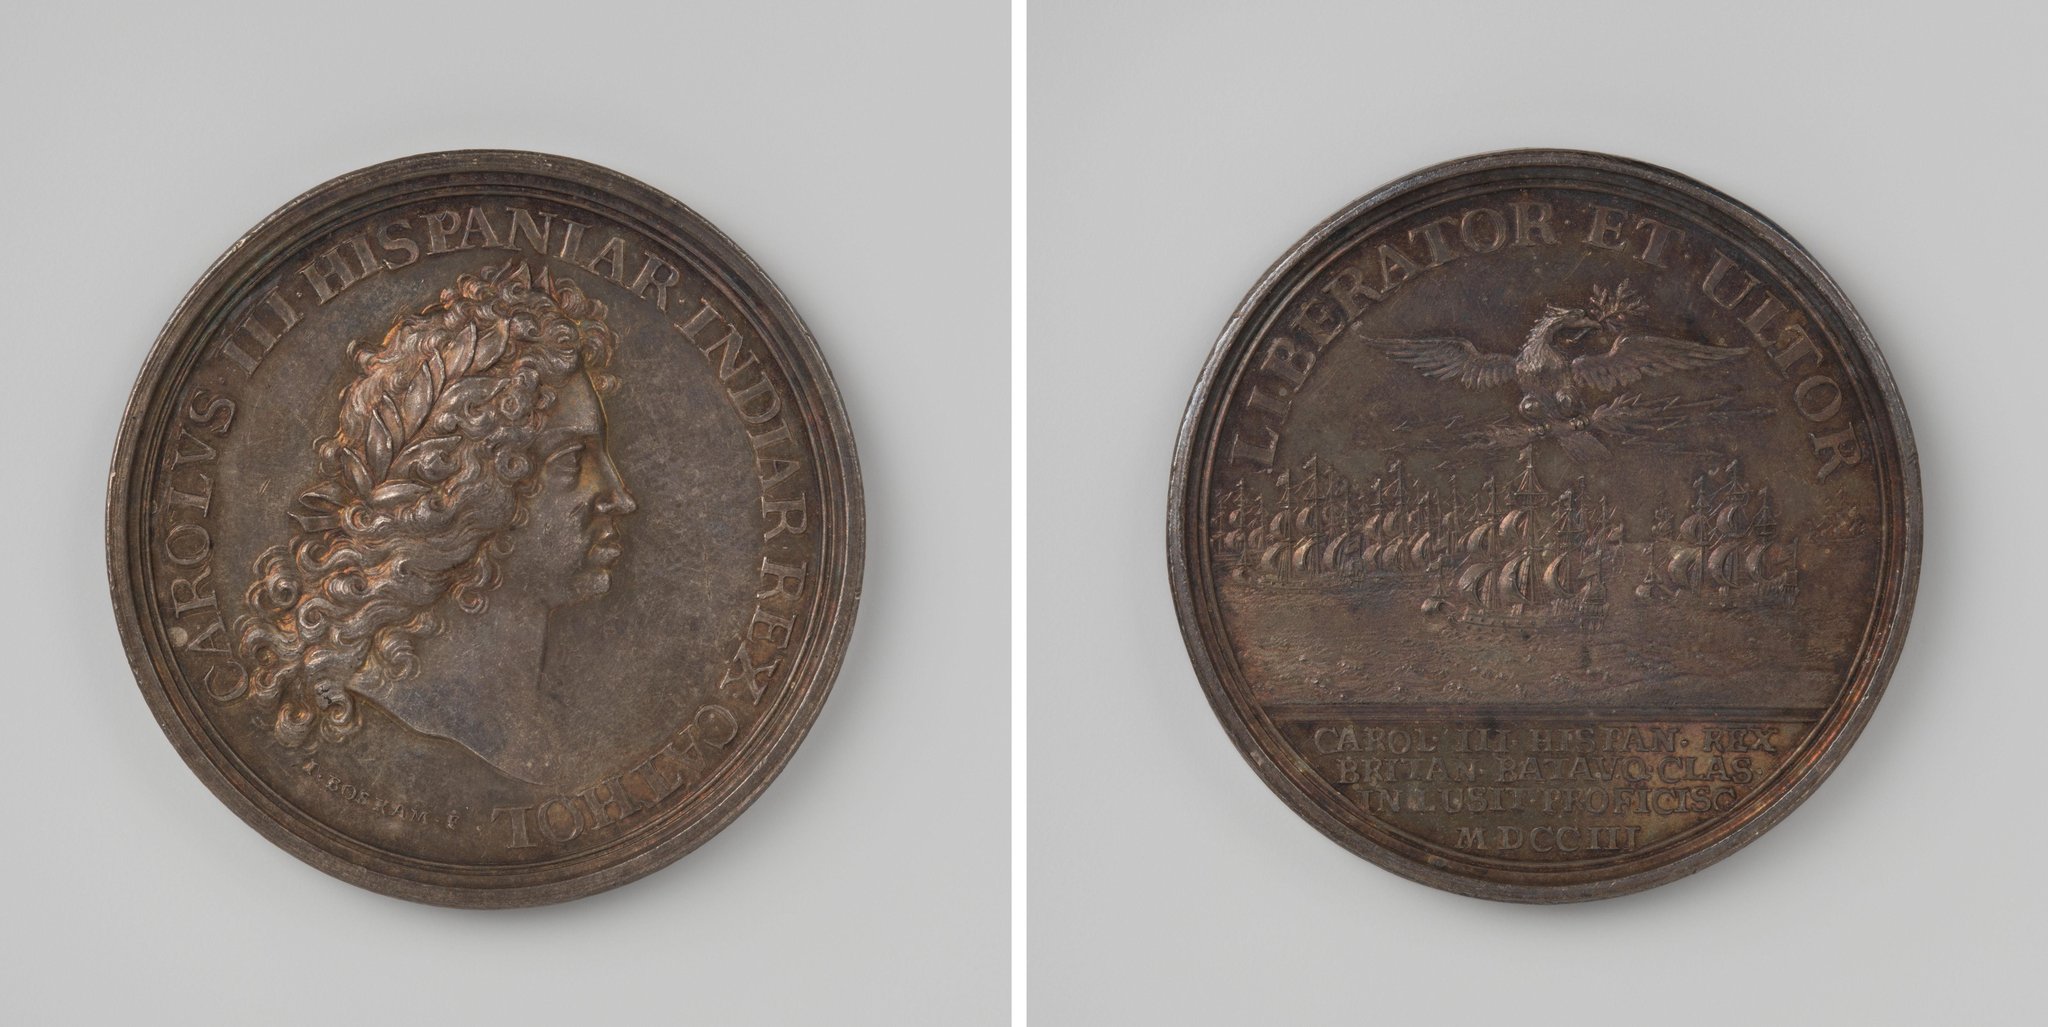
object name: history medal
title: Aankomst van Karel III, koning van Spanje in Portugal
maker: jan boskam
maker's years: 1687-1708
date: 1704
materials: silver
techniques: striking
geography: berlin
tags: vienna, charles vi (holy roman emperor)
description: Zilveren penning. Voorzijde: borststuk man met lauwerkrans binnen omschrift. Keerzijde: keizerlijke arend met olijftak in bek en bliksem in klauwen vliegend boven vloot binnen omschrift, boven opschrift